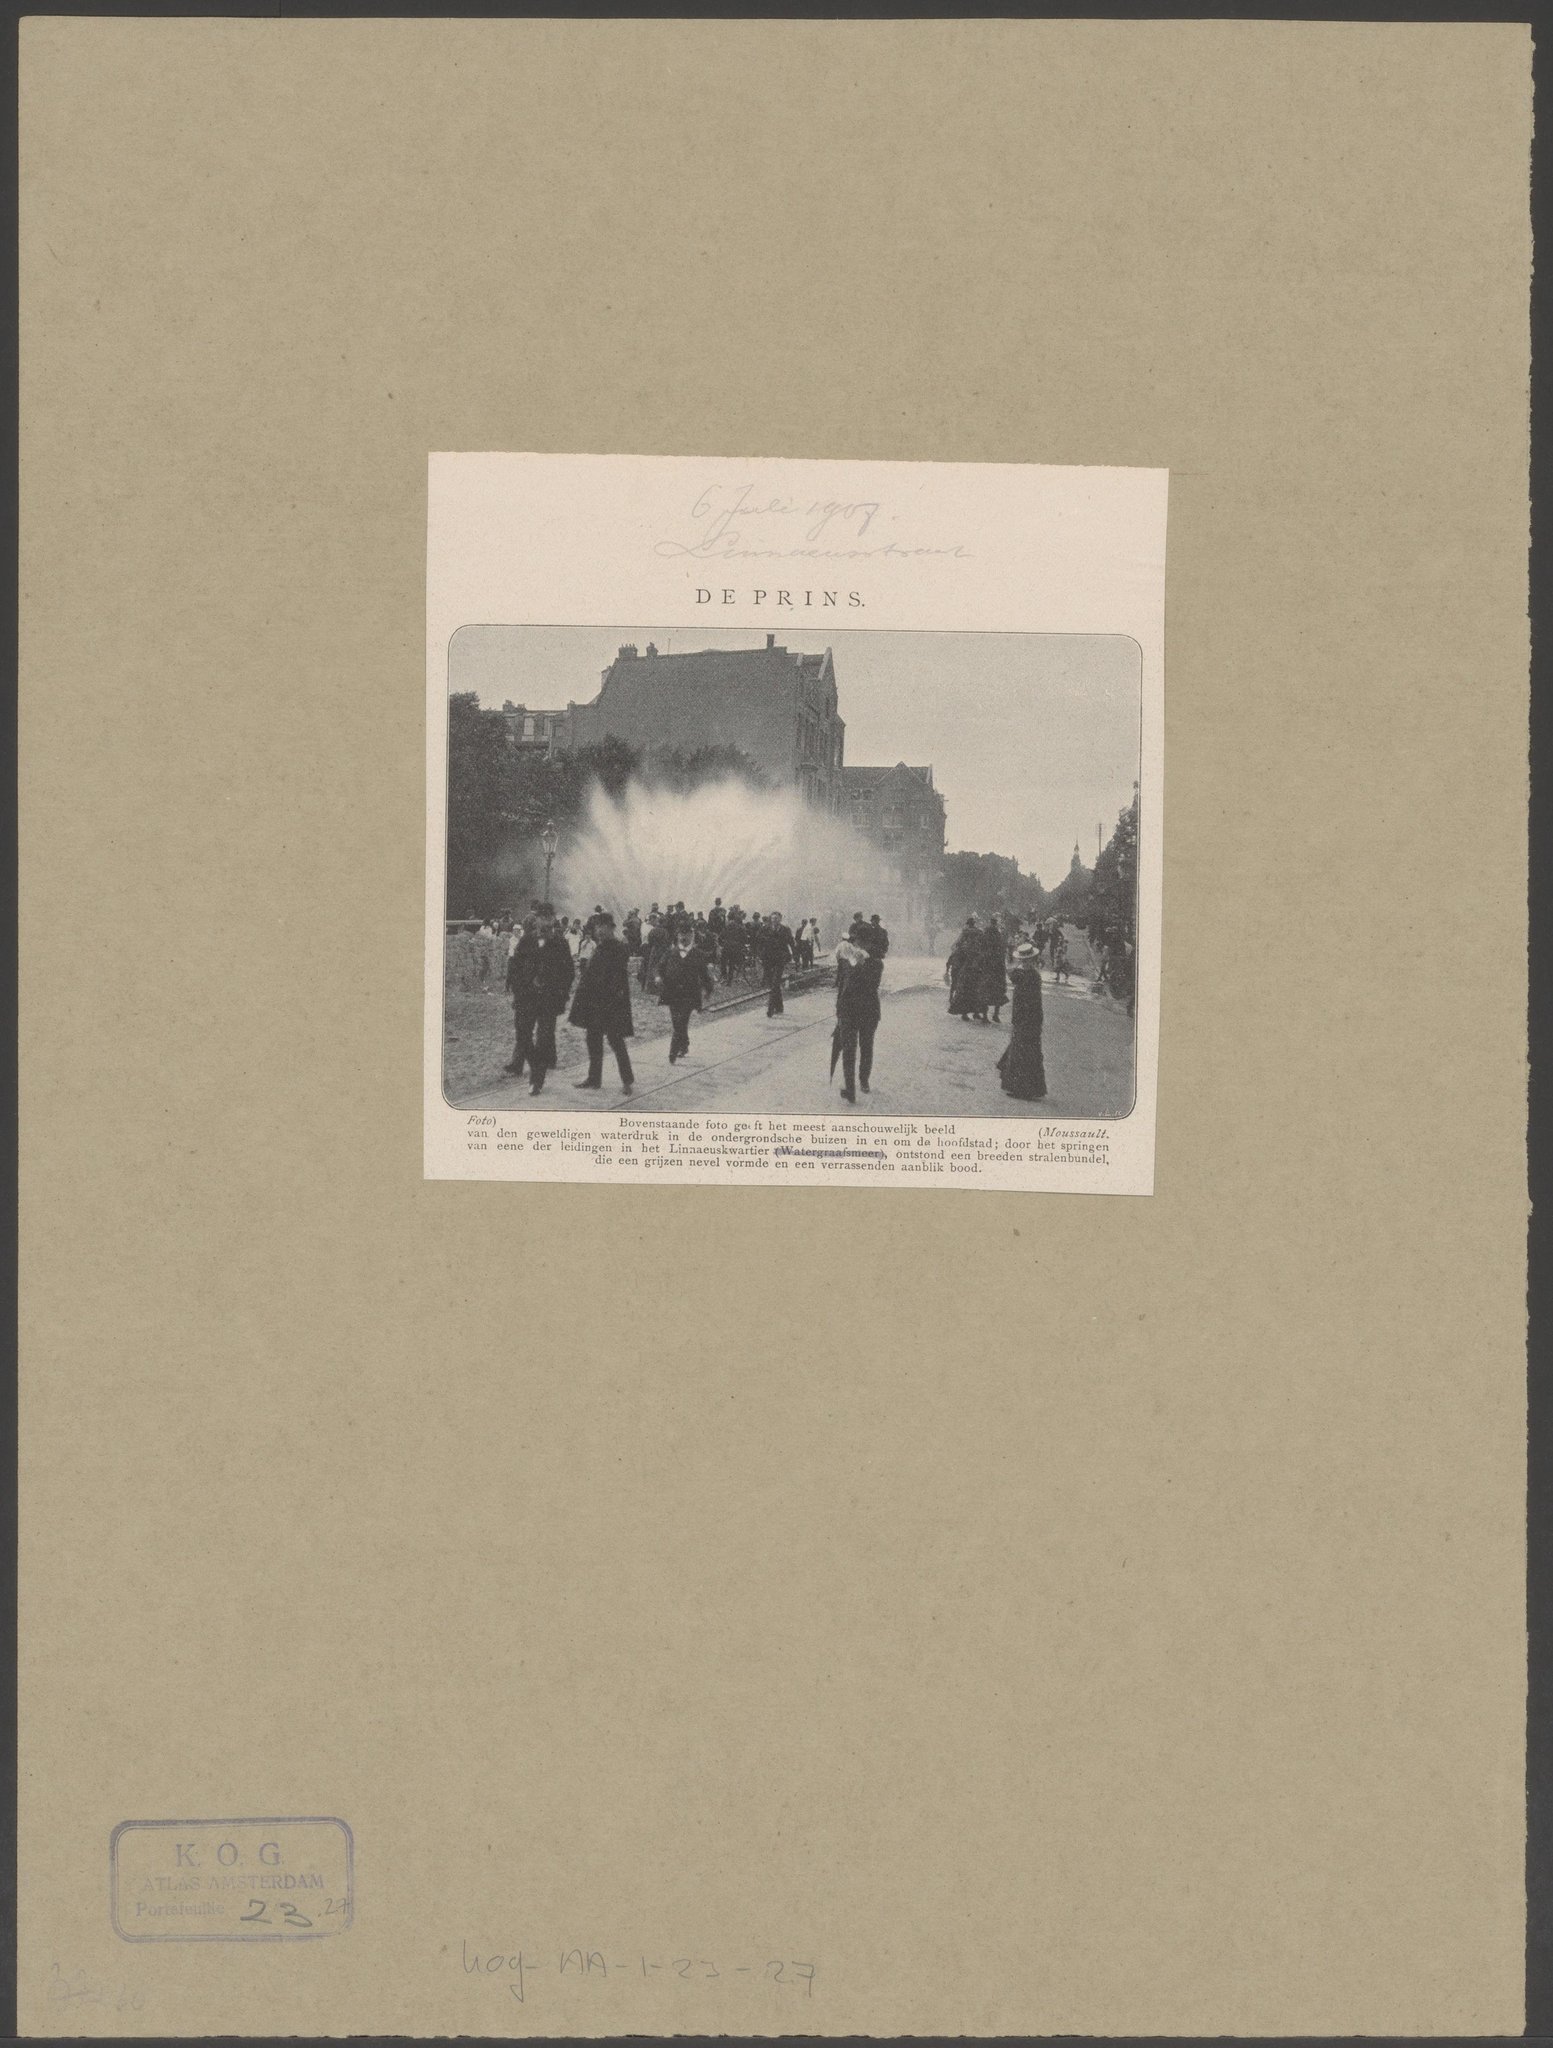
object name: photomechanical print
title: Toeschouwers bekijken opspuitend water na een leidingbreuk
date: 1907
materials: paper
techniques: letterpress printing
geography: amsterdam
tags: crowd, mob, pipe system (~ water supply)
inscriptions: collector's mark: Lugt 1641b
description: Onderwerpsrubriek binnen de Atlas Amsterdam: Gemeentebedrijven.